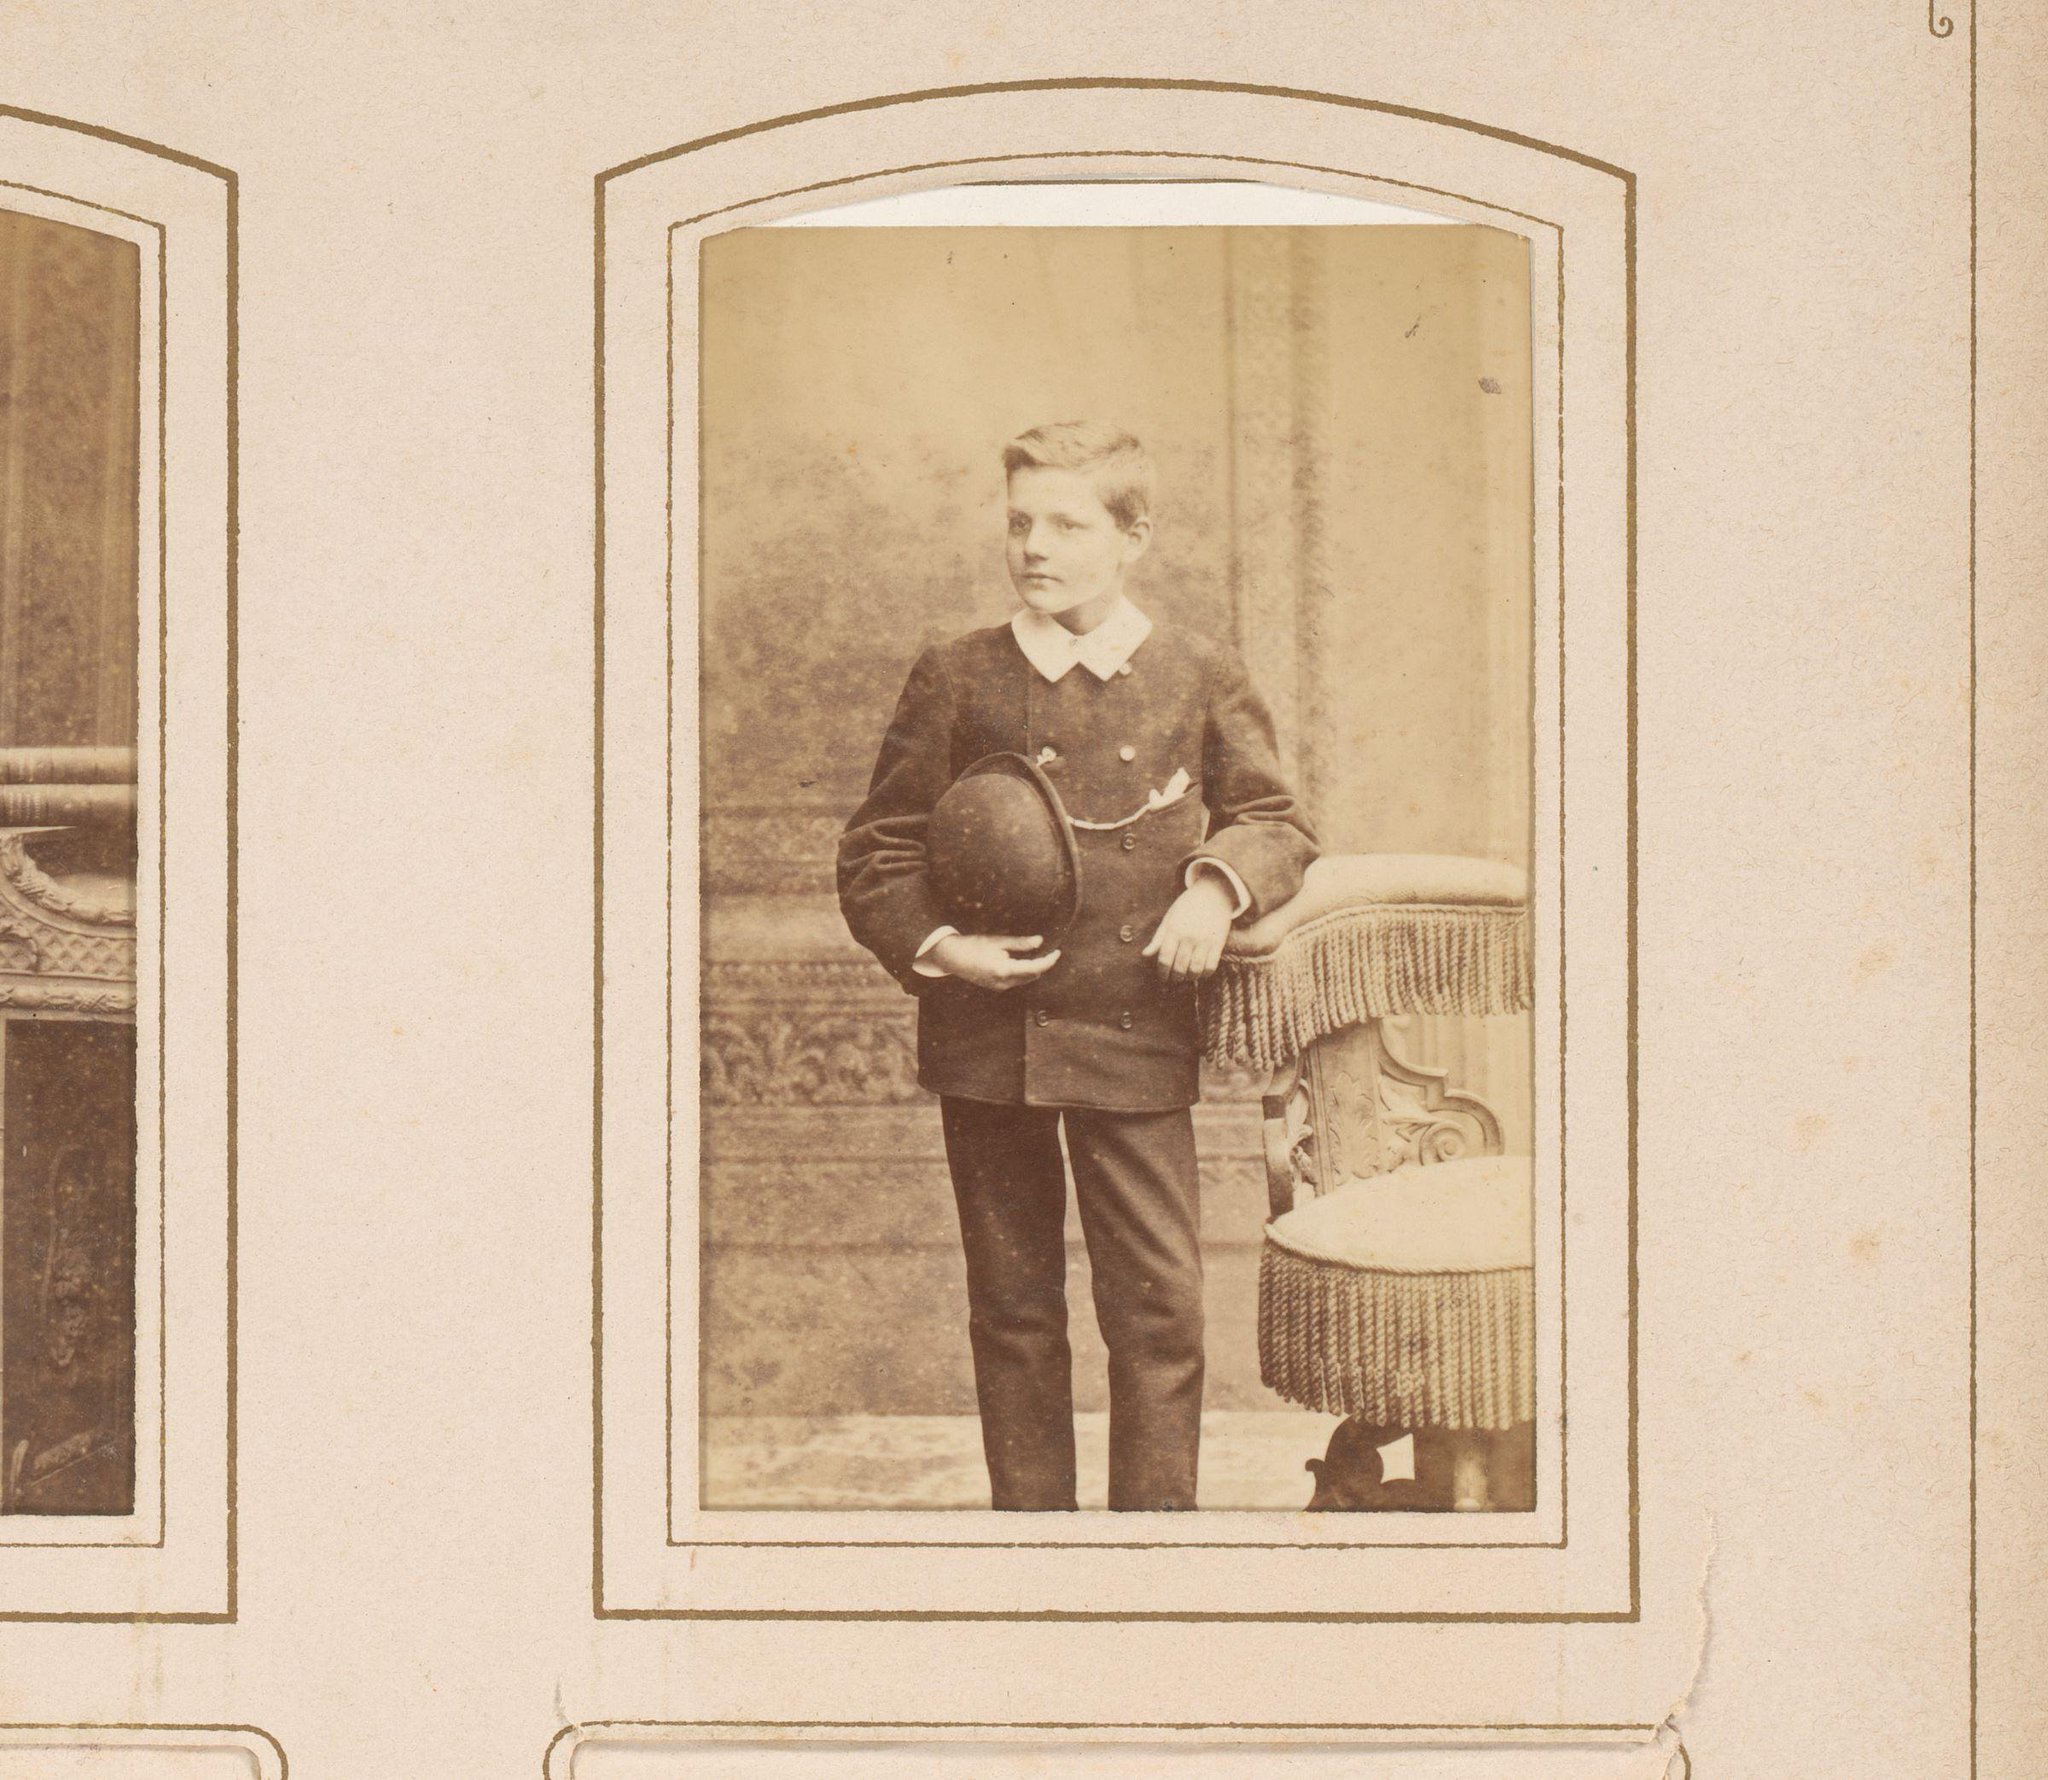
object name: photograph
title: Portret van een jongen met hoed in de hand, staand bij een stoel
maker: carel eduard westerborg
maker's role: fotograaf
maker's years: 1842-1916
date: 1861-1900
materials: cardboard, photographic support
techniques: albumen print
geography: arnhem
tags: standing figure, head-gear: bowler hat, boy (child between toddler and youth), historical persons, chair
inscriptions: inscription: ‘C. E. WESTERBORG/ Photograaf/ Vossenstraat B 66/ Arnhem/ Voor nabestelling worden alle/ negatieven bewaard.’